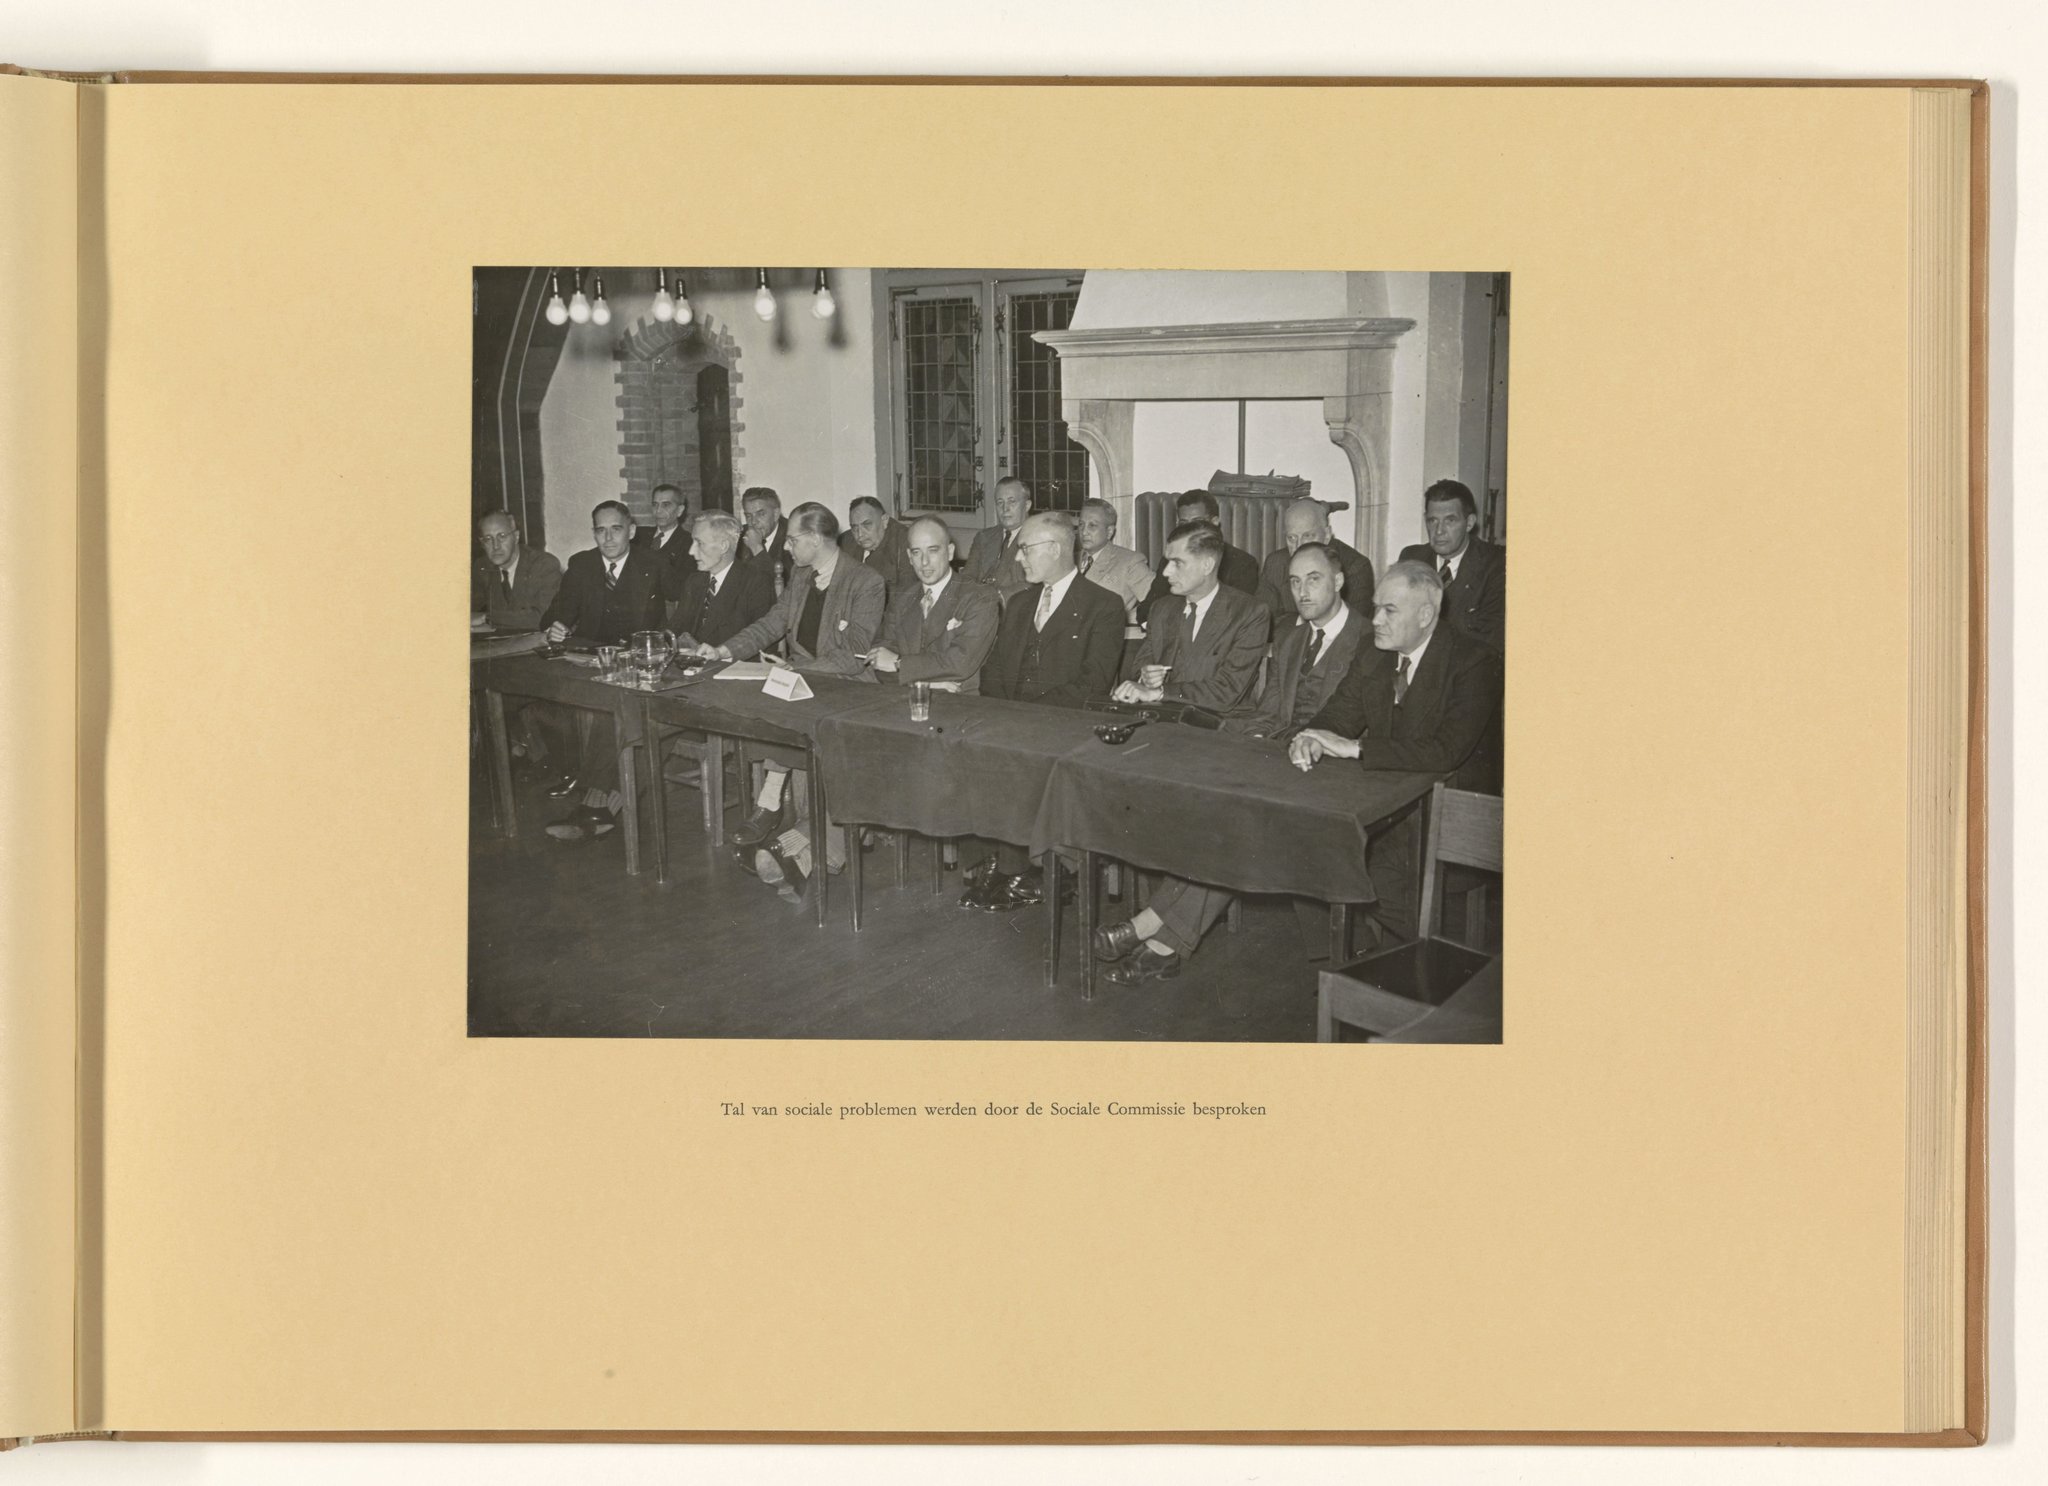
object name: photograph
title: Tal van sociale problemen werden door de Sociale Commissie besproken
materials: paper, photographic support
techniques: gelatin silver print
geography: the hague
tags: binnenhof, rondetafelconferentie (1949)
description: De Sociale Commissie aan het werk. Foto in het fotoalbum met 37 foto's van de rondetafelconferentie gehouden tussen 23 augustus en 2 november in Den Haag in 1949 tussen vertegenwoordigers van Nederland, de Republiek Indonesië en de Bijeenkomst Federaal Overleg. Het exemplaar aangeboden aan premier Willem Drees.